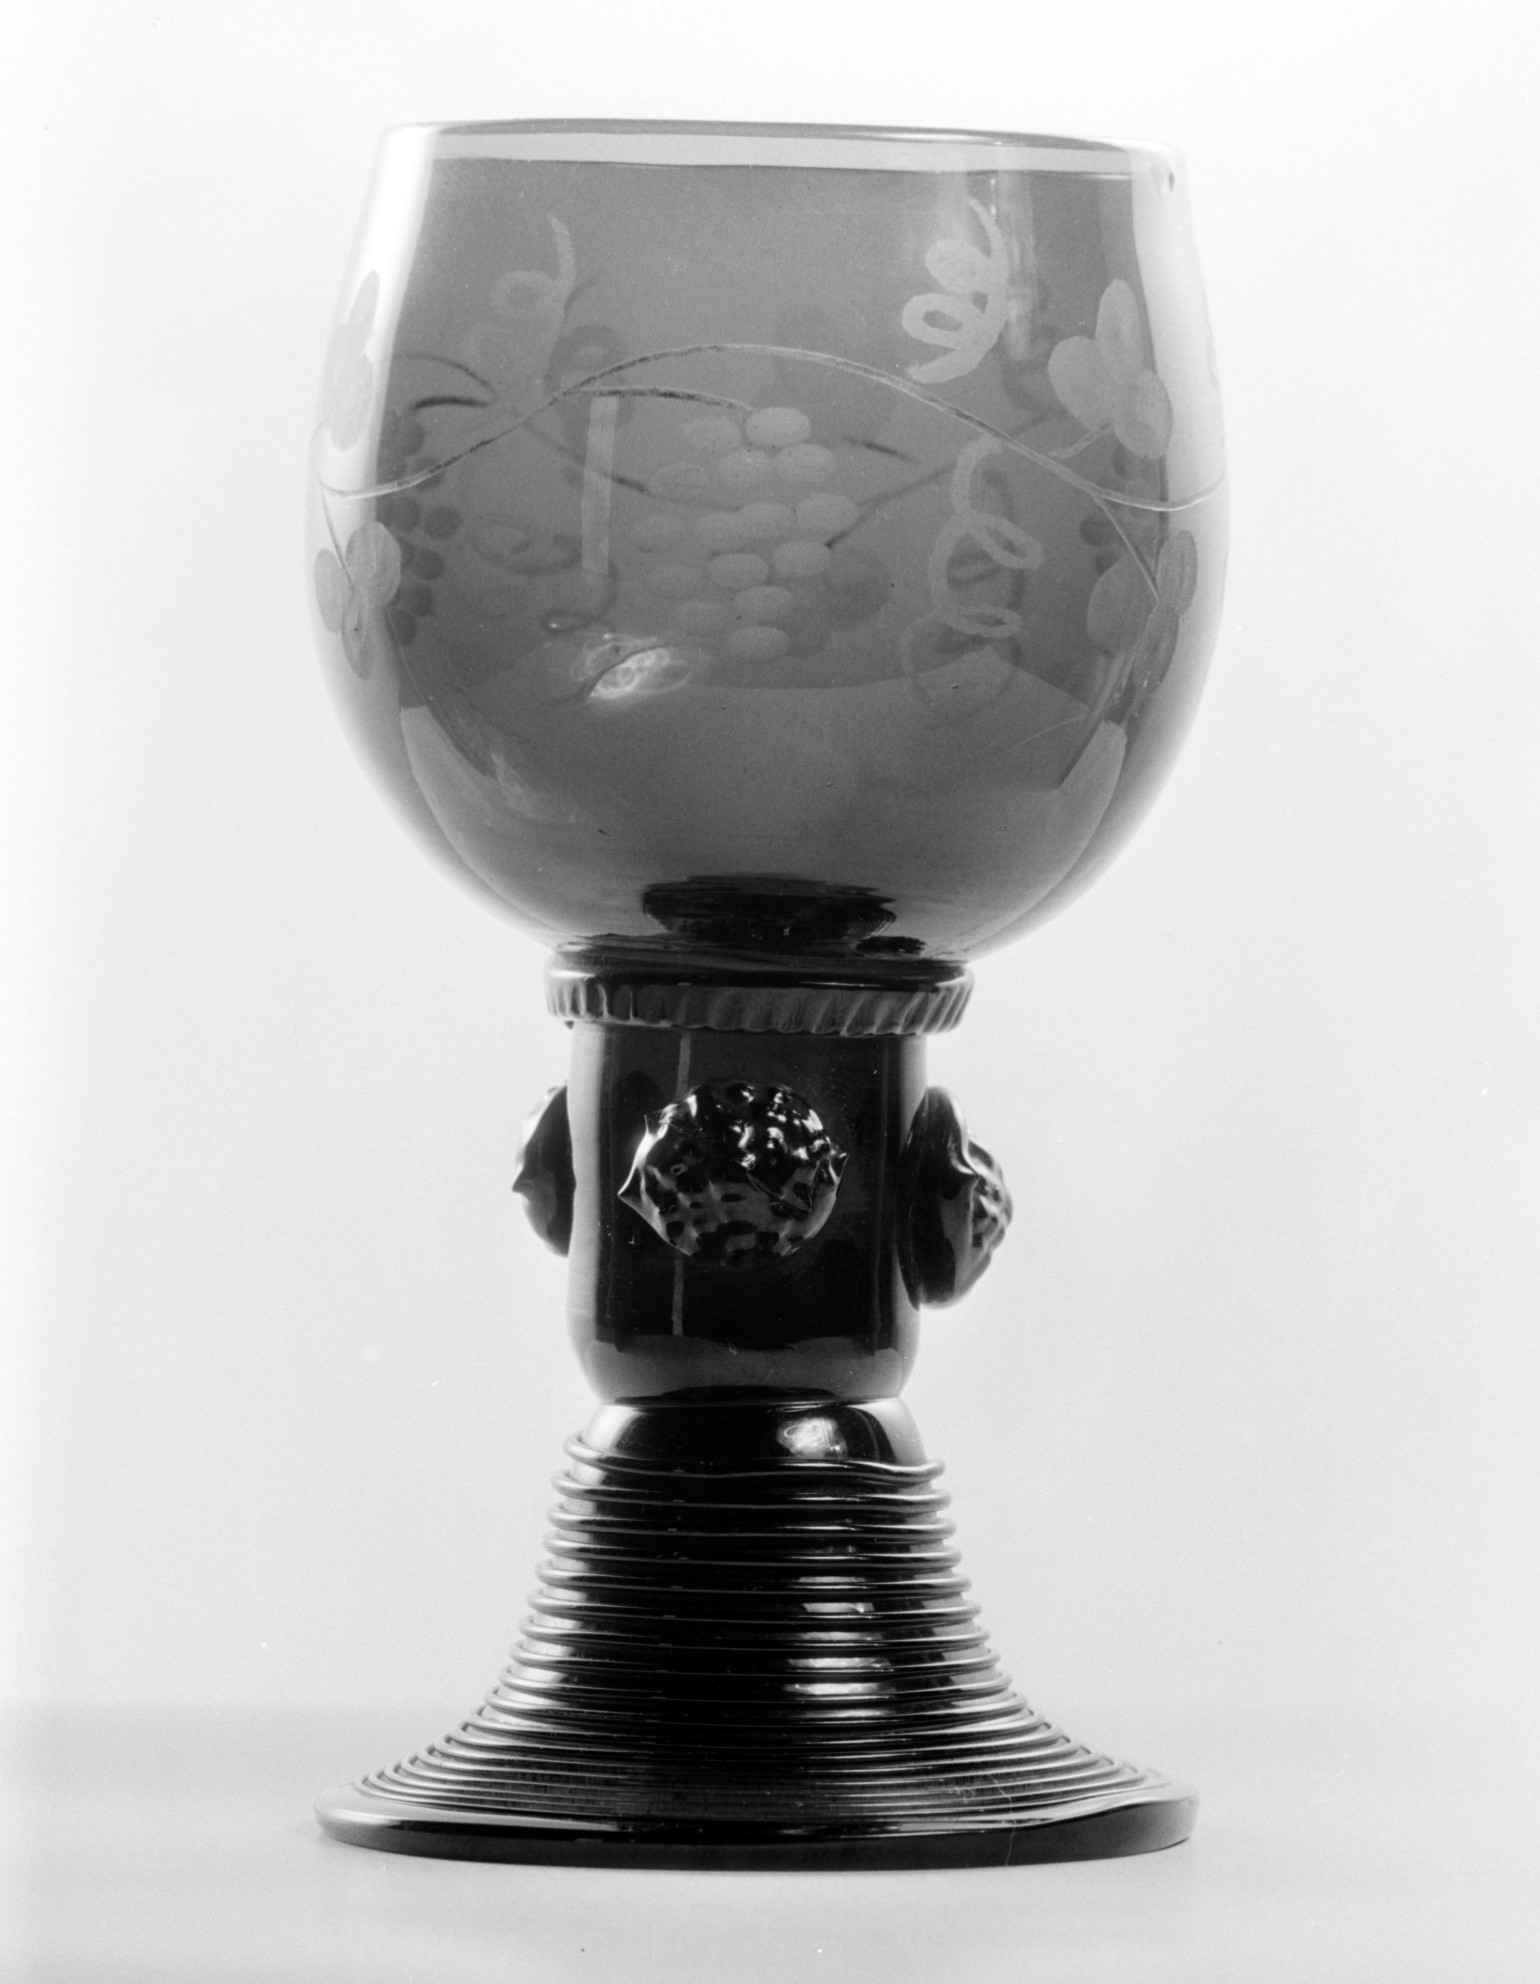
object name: goblet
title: Goblet (Roemer)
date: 1801-1833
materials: glass